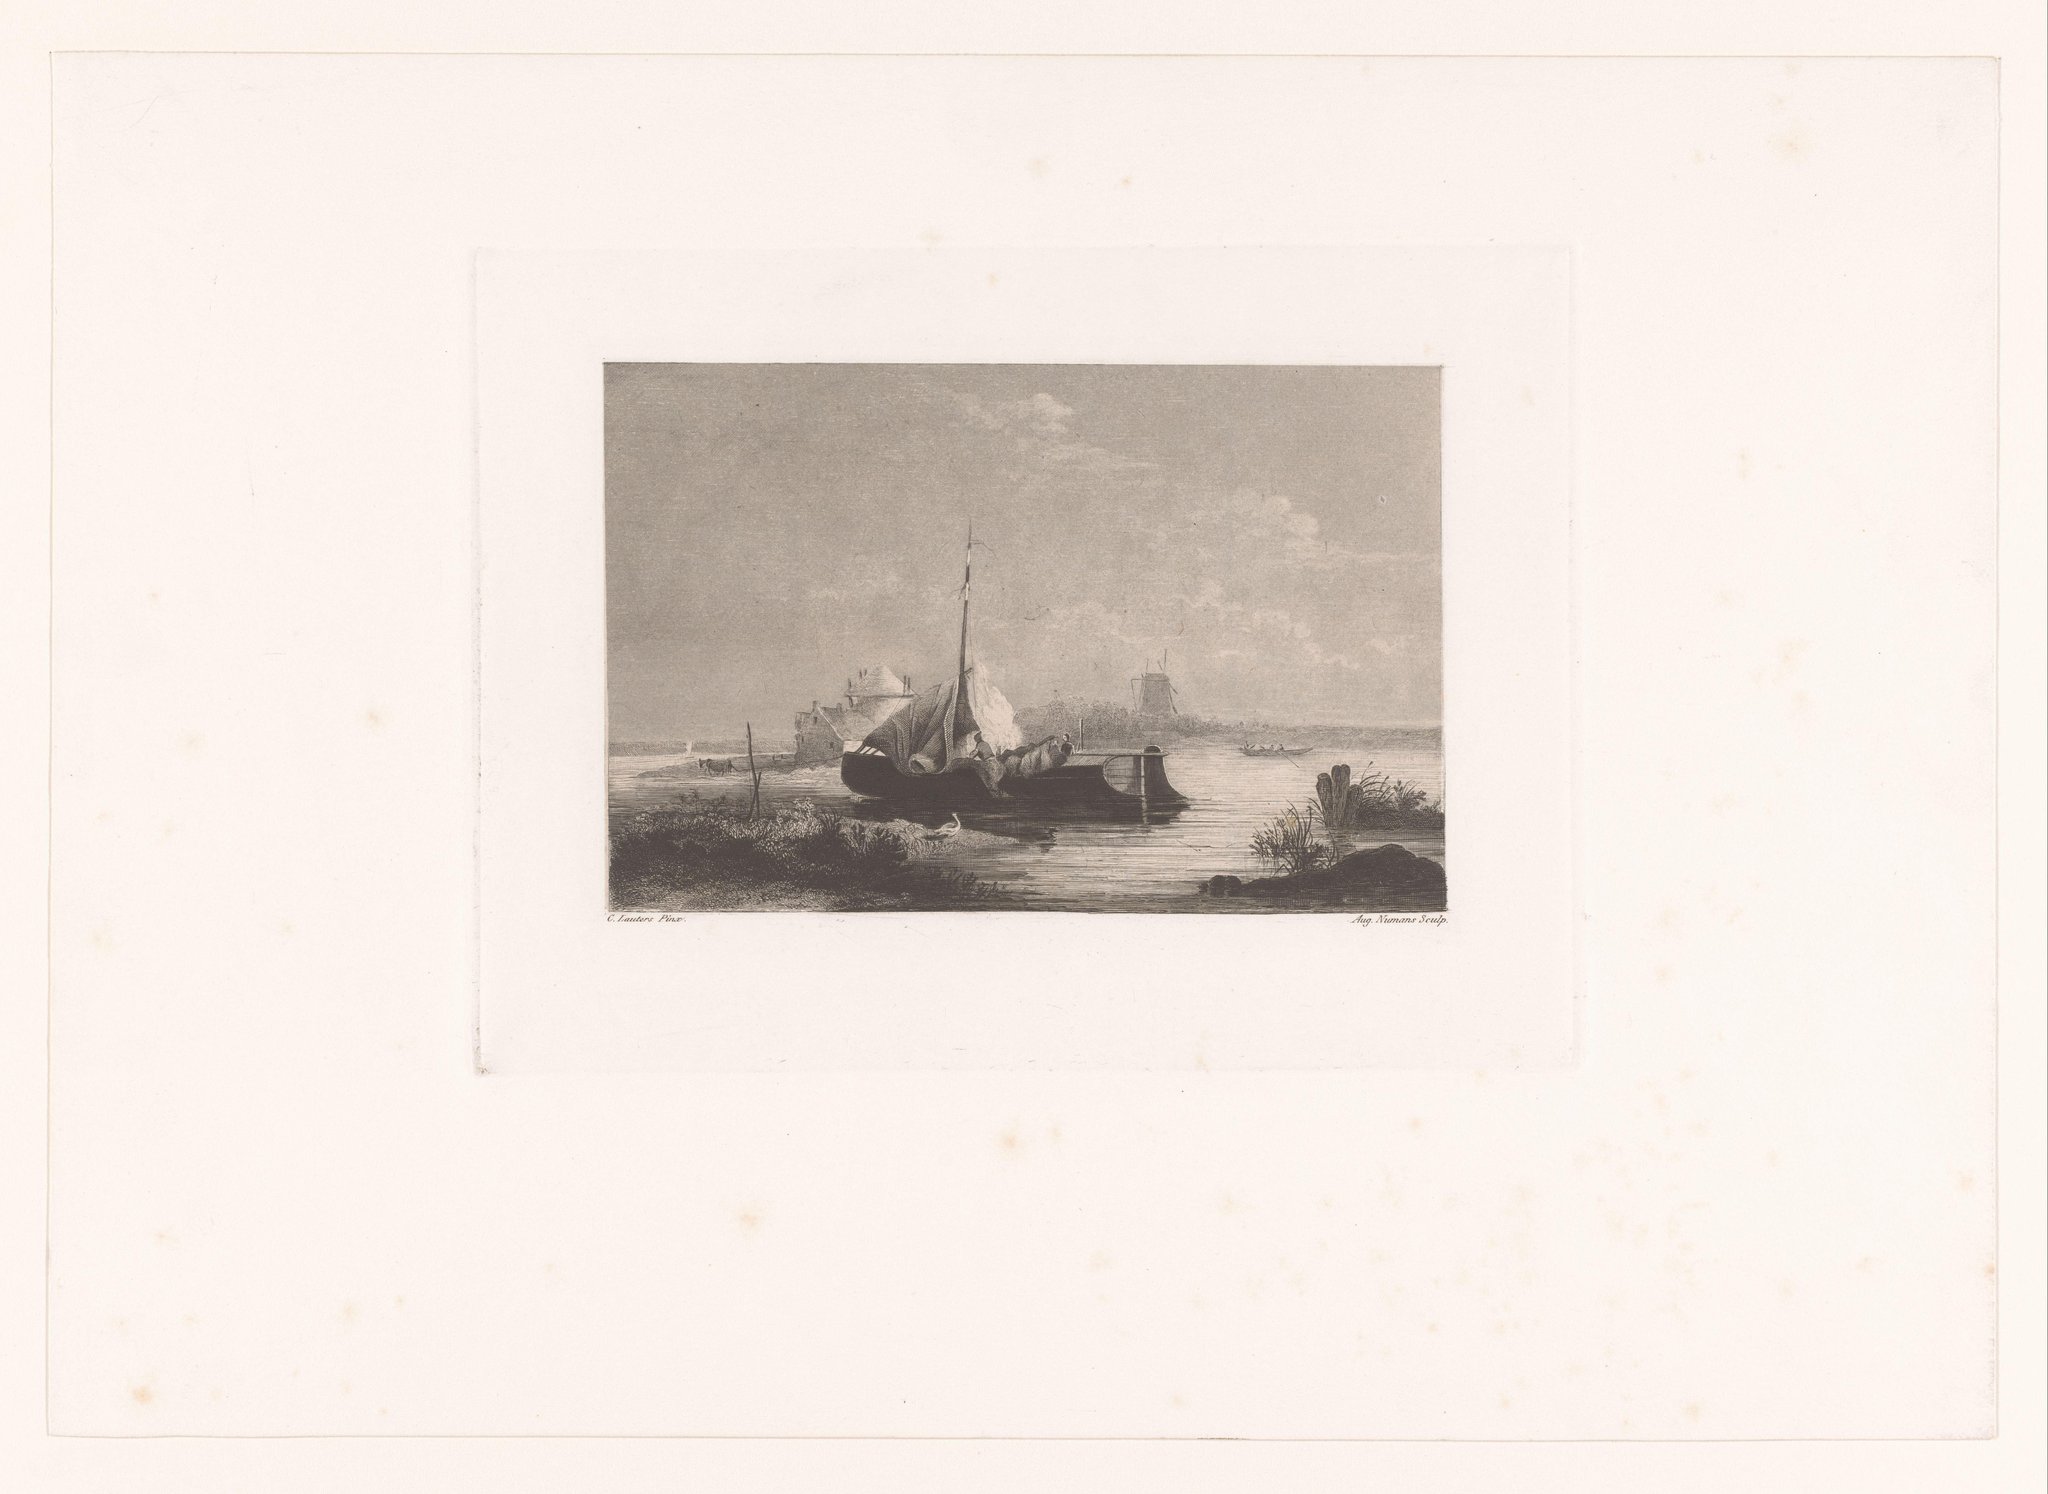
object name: print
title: Landschappen door Auguste Numans naar andere kunstenaars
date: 1833-1879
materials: paper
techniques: etching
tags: windmill in landscape, tow-boat, towing-barge, landscapes with waters, waterscapes, seascapes (in the temperate zone) (+ landscape with figures, staffage)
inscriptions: collector's mark: Lugt 2228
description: Deze prent behoort tot een prentserie met diverse landschappen in prent gebracht door Auguste Numans naar voorbeelden van andere kunstenaars.